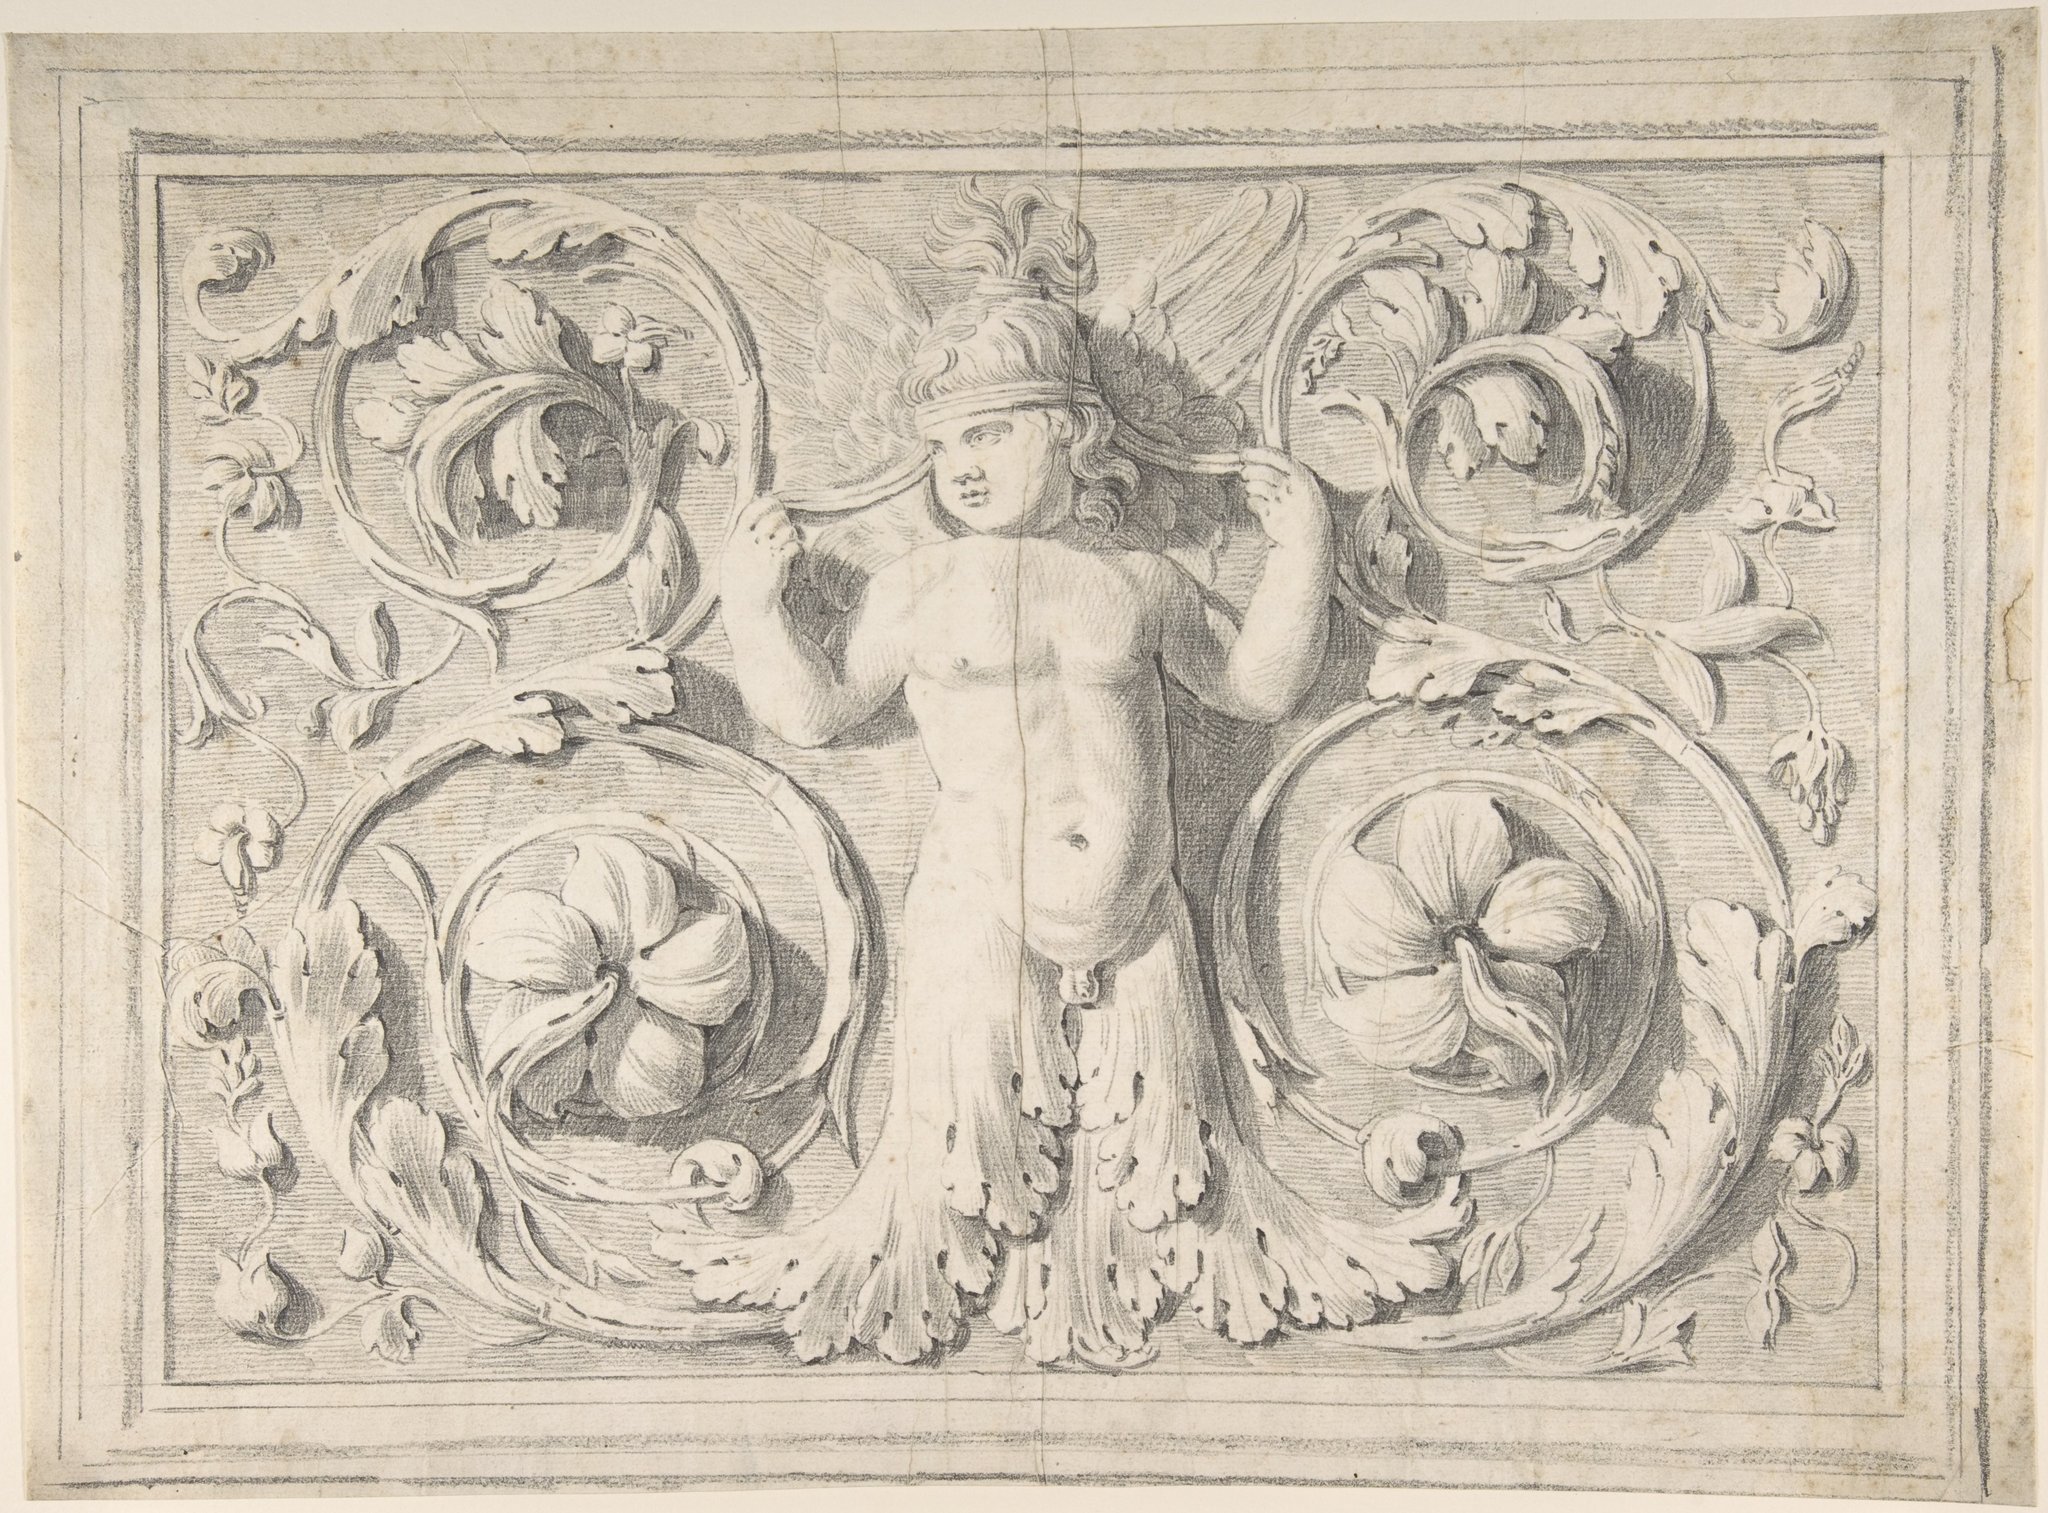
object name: drawing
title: Antique Roman Sculpture with Nude Winged Boy at the Center and Leaves and Vines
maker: thomas hardwick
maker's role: artist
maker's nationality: british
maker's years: 1752-1829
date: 1776-1779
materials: graphite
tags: sculpture,boys,male nudes,vines